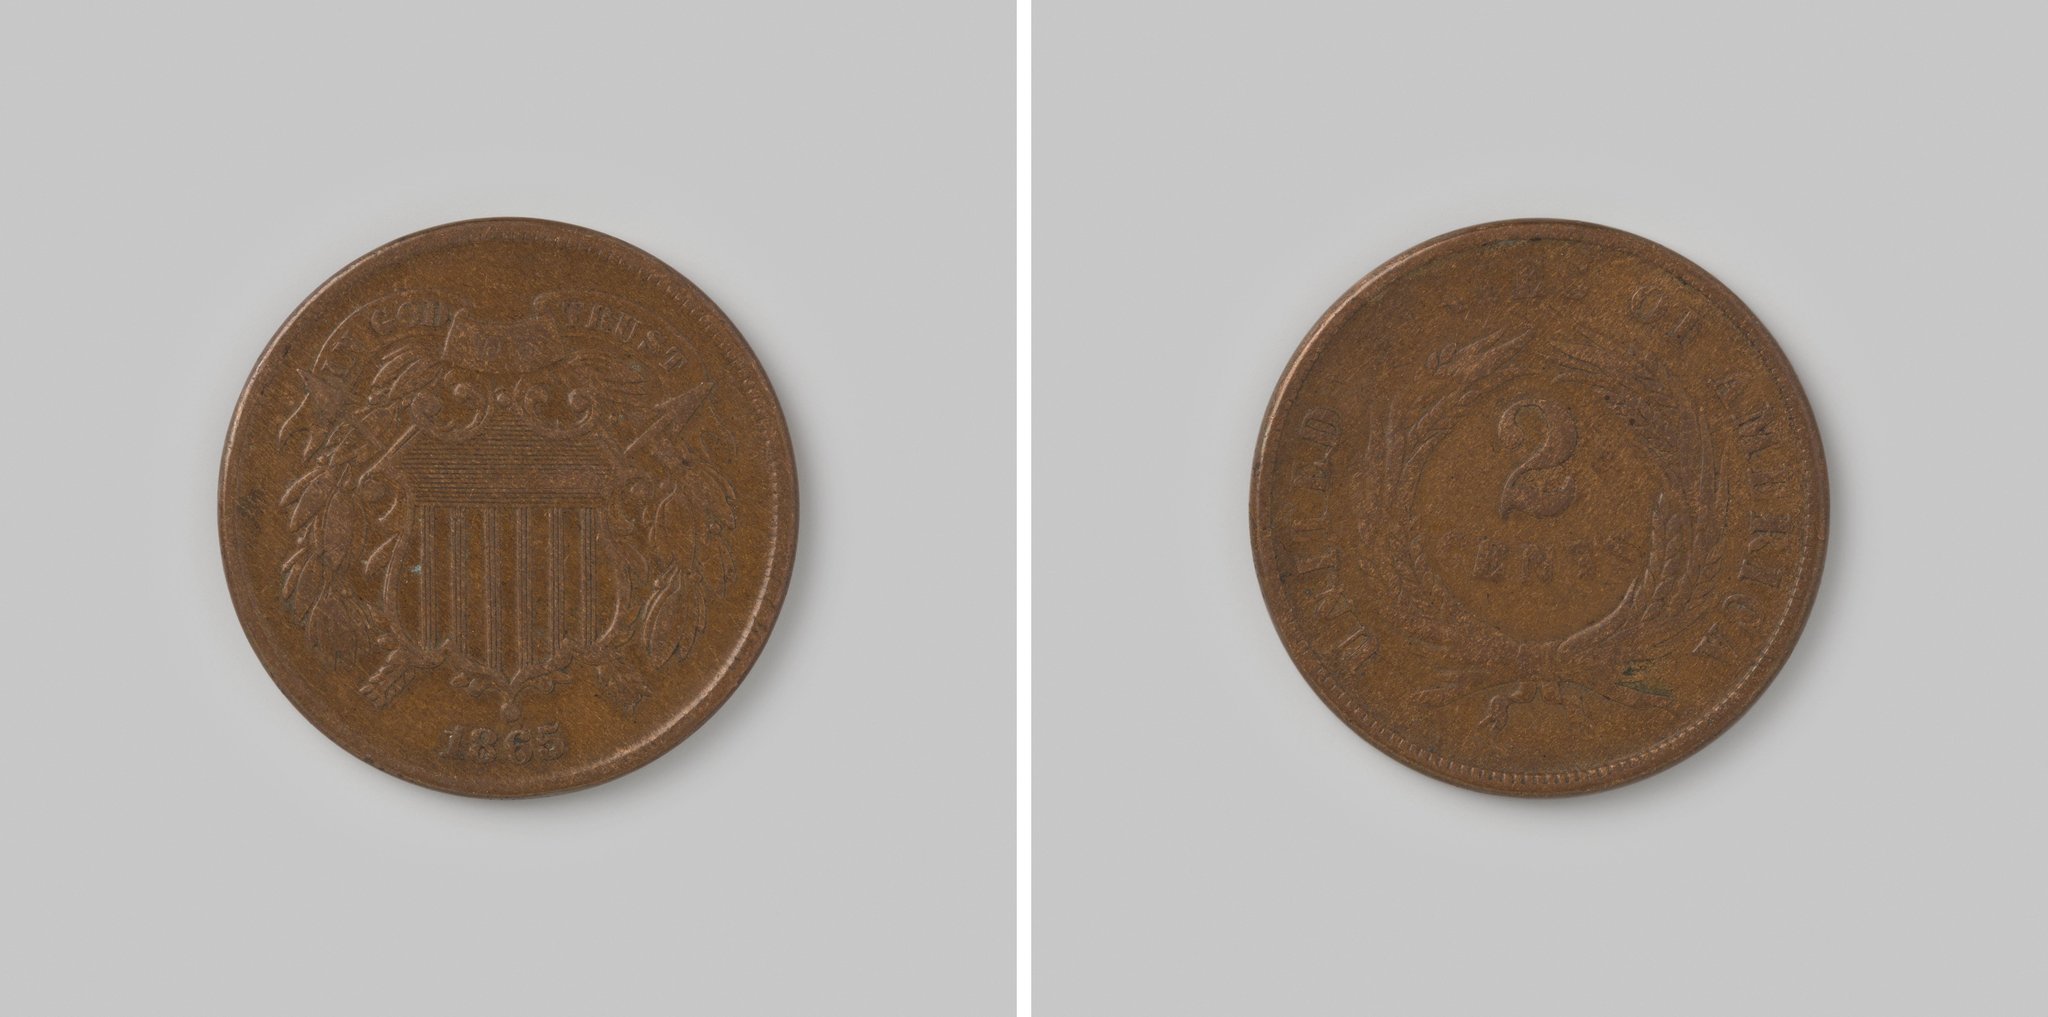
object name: coin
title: 2 cents uit de Verenigde Staten van Amerika, 1865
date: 1865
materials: bronze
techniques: striking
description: Bronzen munt. Voorzijde: banderol met opschrift, waaronder twee hangende takken. Daarbinnen op twee gekruiste pijlen ingebogen wapenschild. Onderaan jaartal. Keerzijde: tussen twee samengebonden korenaren waarde-aanduiding: 2 cents in twee regels. Gladde rand.